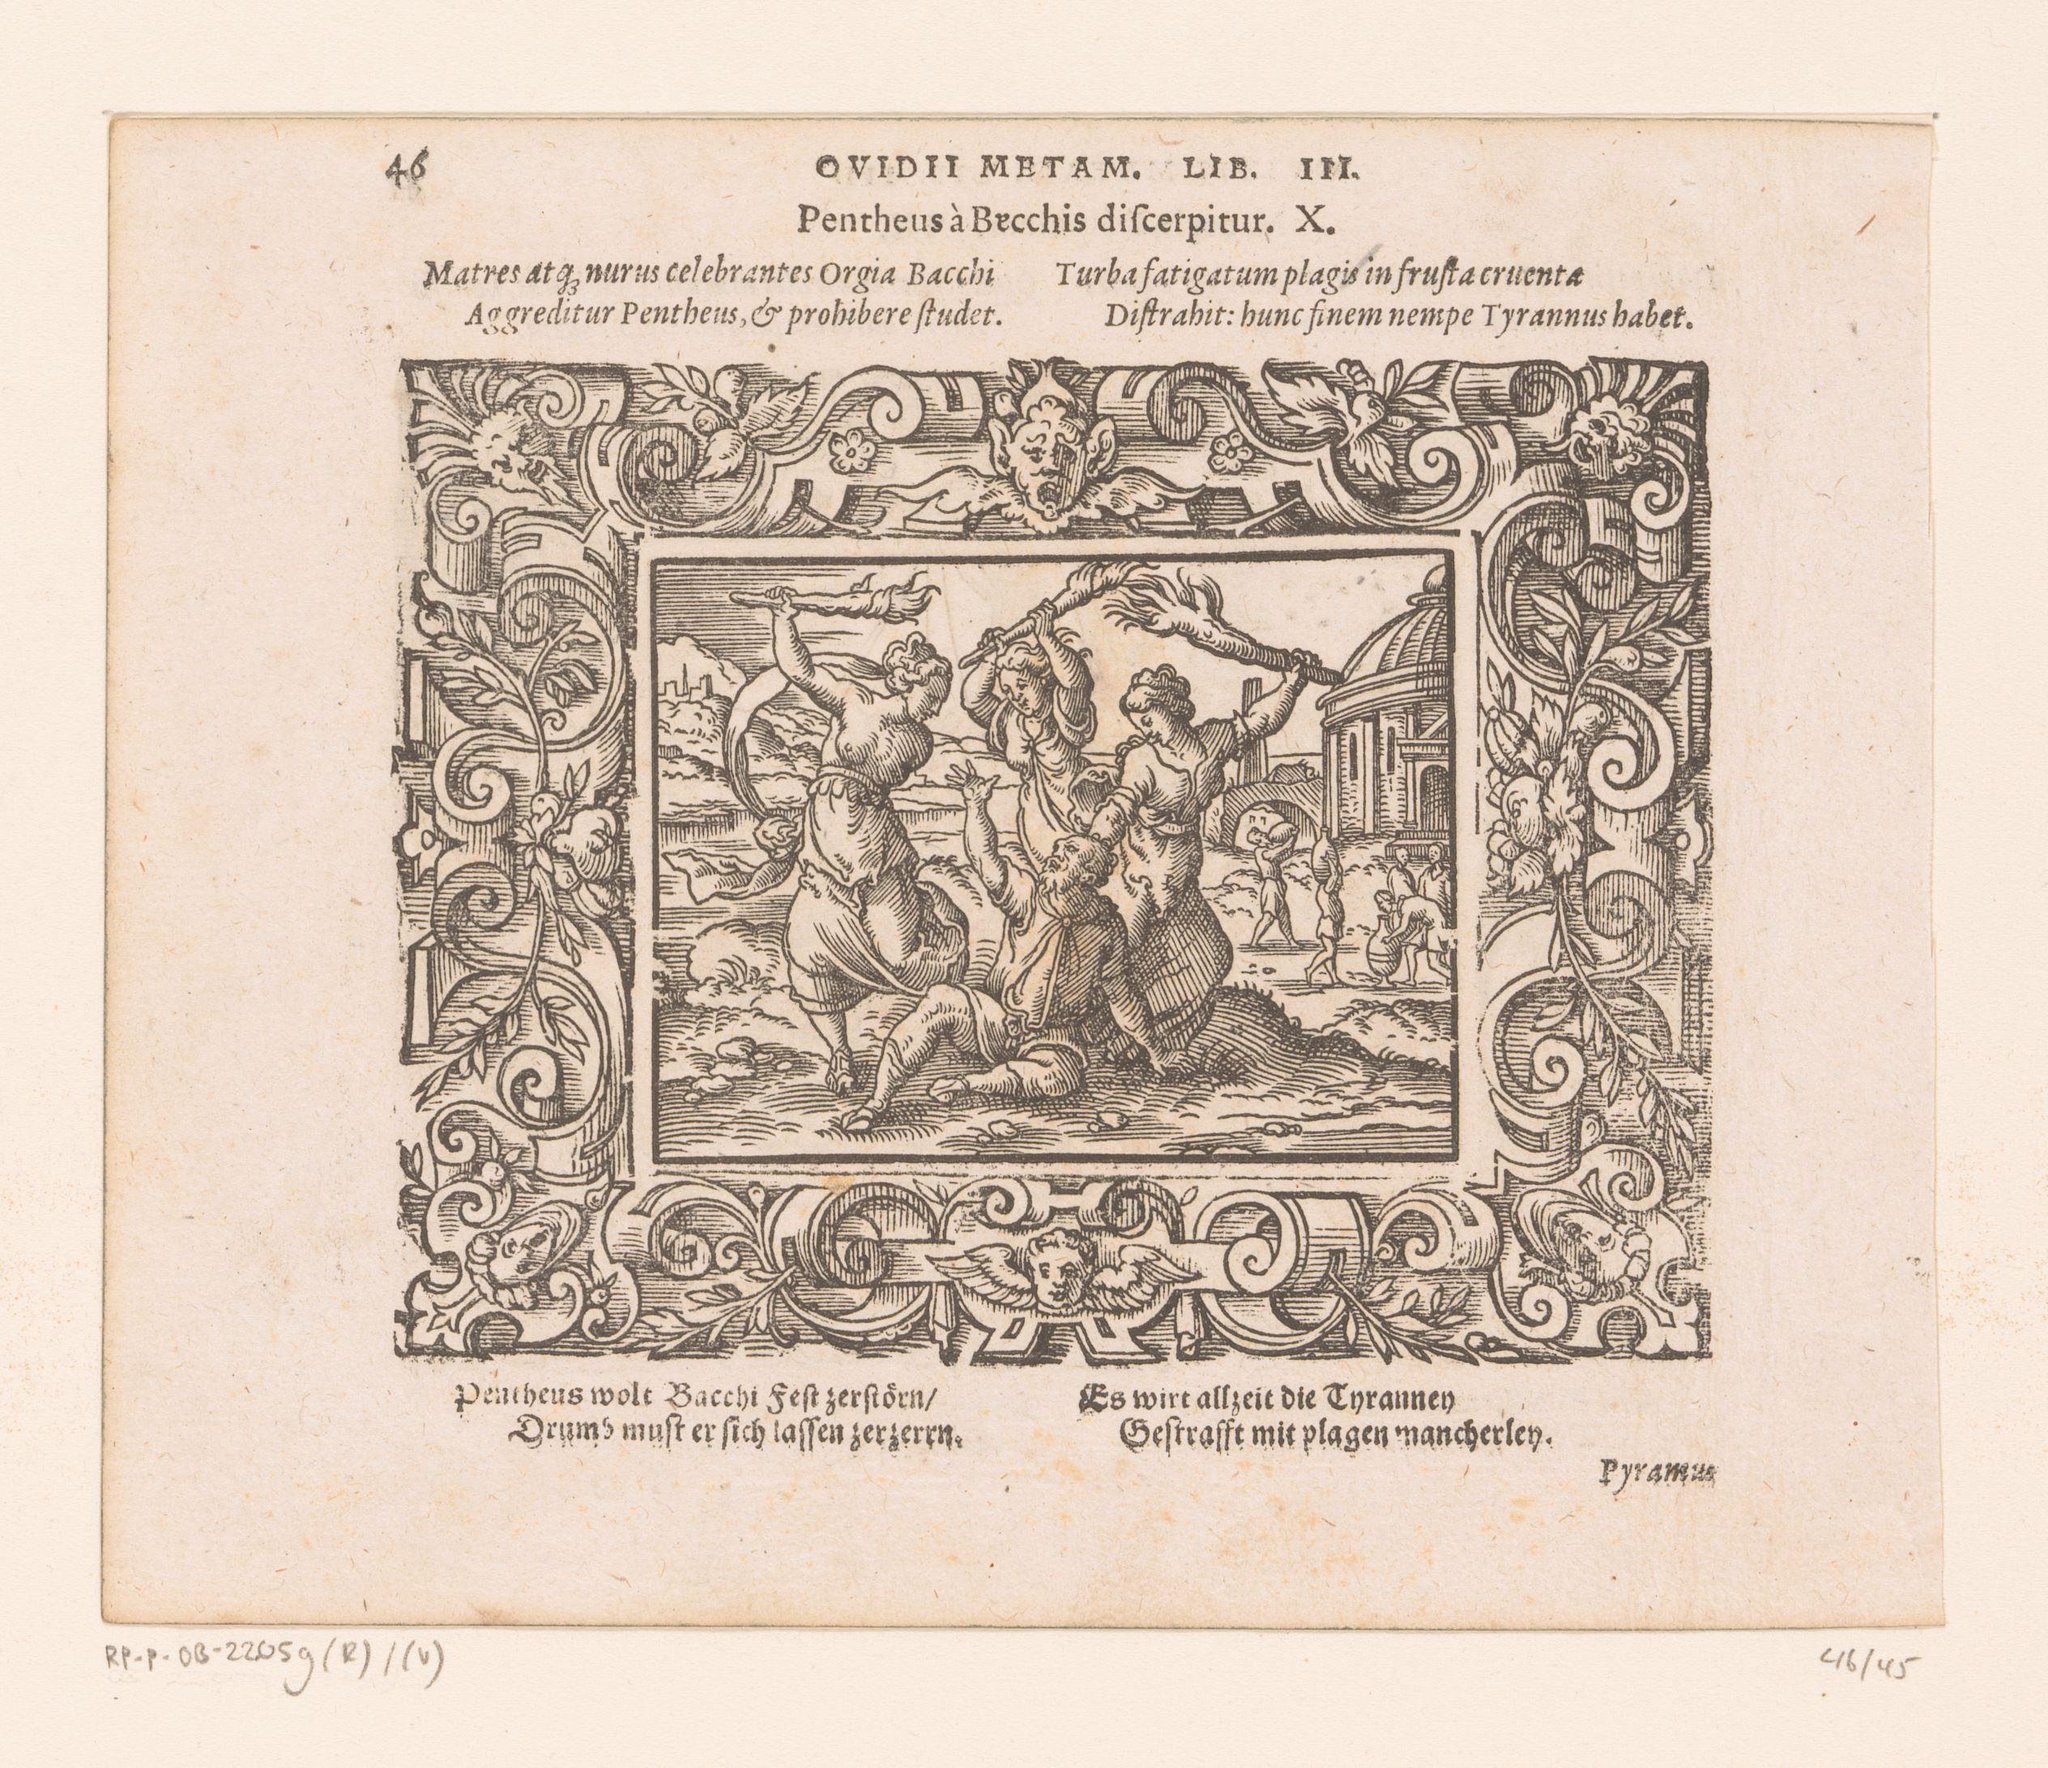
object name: print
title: Pentheus à Bacchis discerpitur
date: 1569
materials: paper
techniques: letterpress printing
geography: frankfurt am main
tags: scrollwork, strapwork ~ ornament, death of pentheus: during a bacchic orgy he is torn to pieces by his mother agave and other women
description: Illustratie bij de Metamorfosen van Ovidius, afkomstig uit de publicatie: Posthius, Johannes. Tetrasticha in Ovidii metam. Frankfurt am Main: Georg Rab en Sigmund Feyerabend en erven Weigand Han, 1569. De voorstellingen en ornamentranden van deze boekillustraties zijn van twee aparte blokken gedrukt. Beide werden afzonderlijk van elkaar ook gebruikt voor andere publicaties, en de ornamentranden werden eveneens binnen deze publicatie meerdere keren gebruikt.